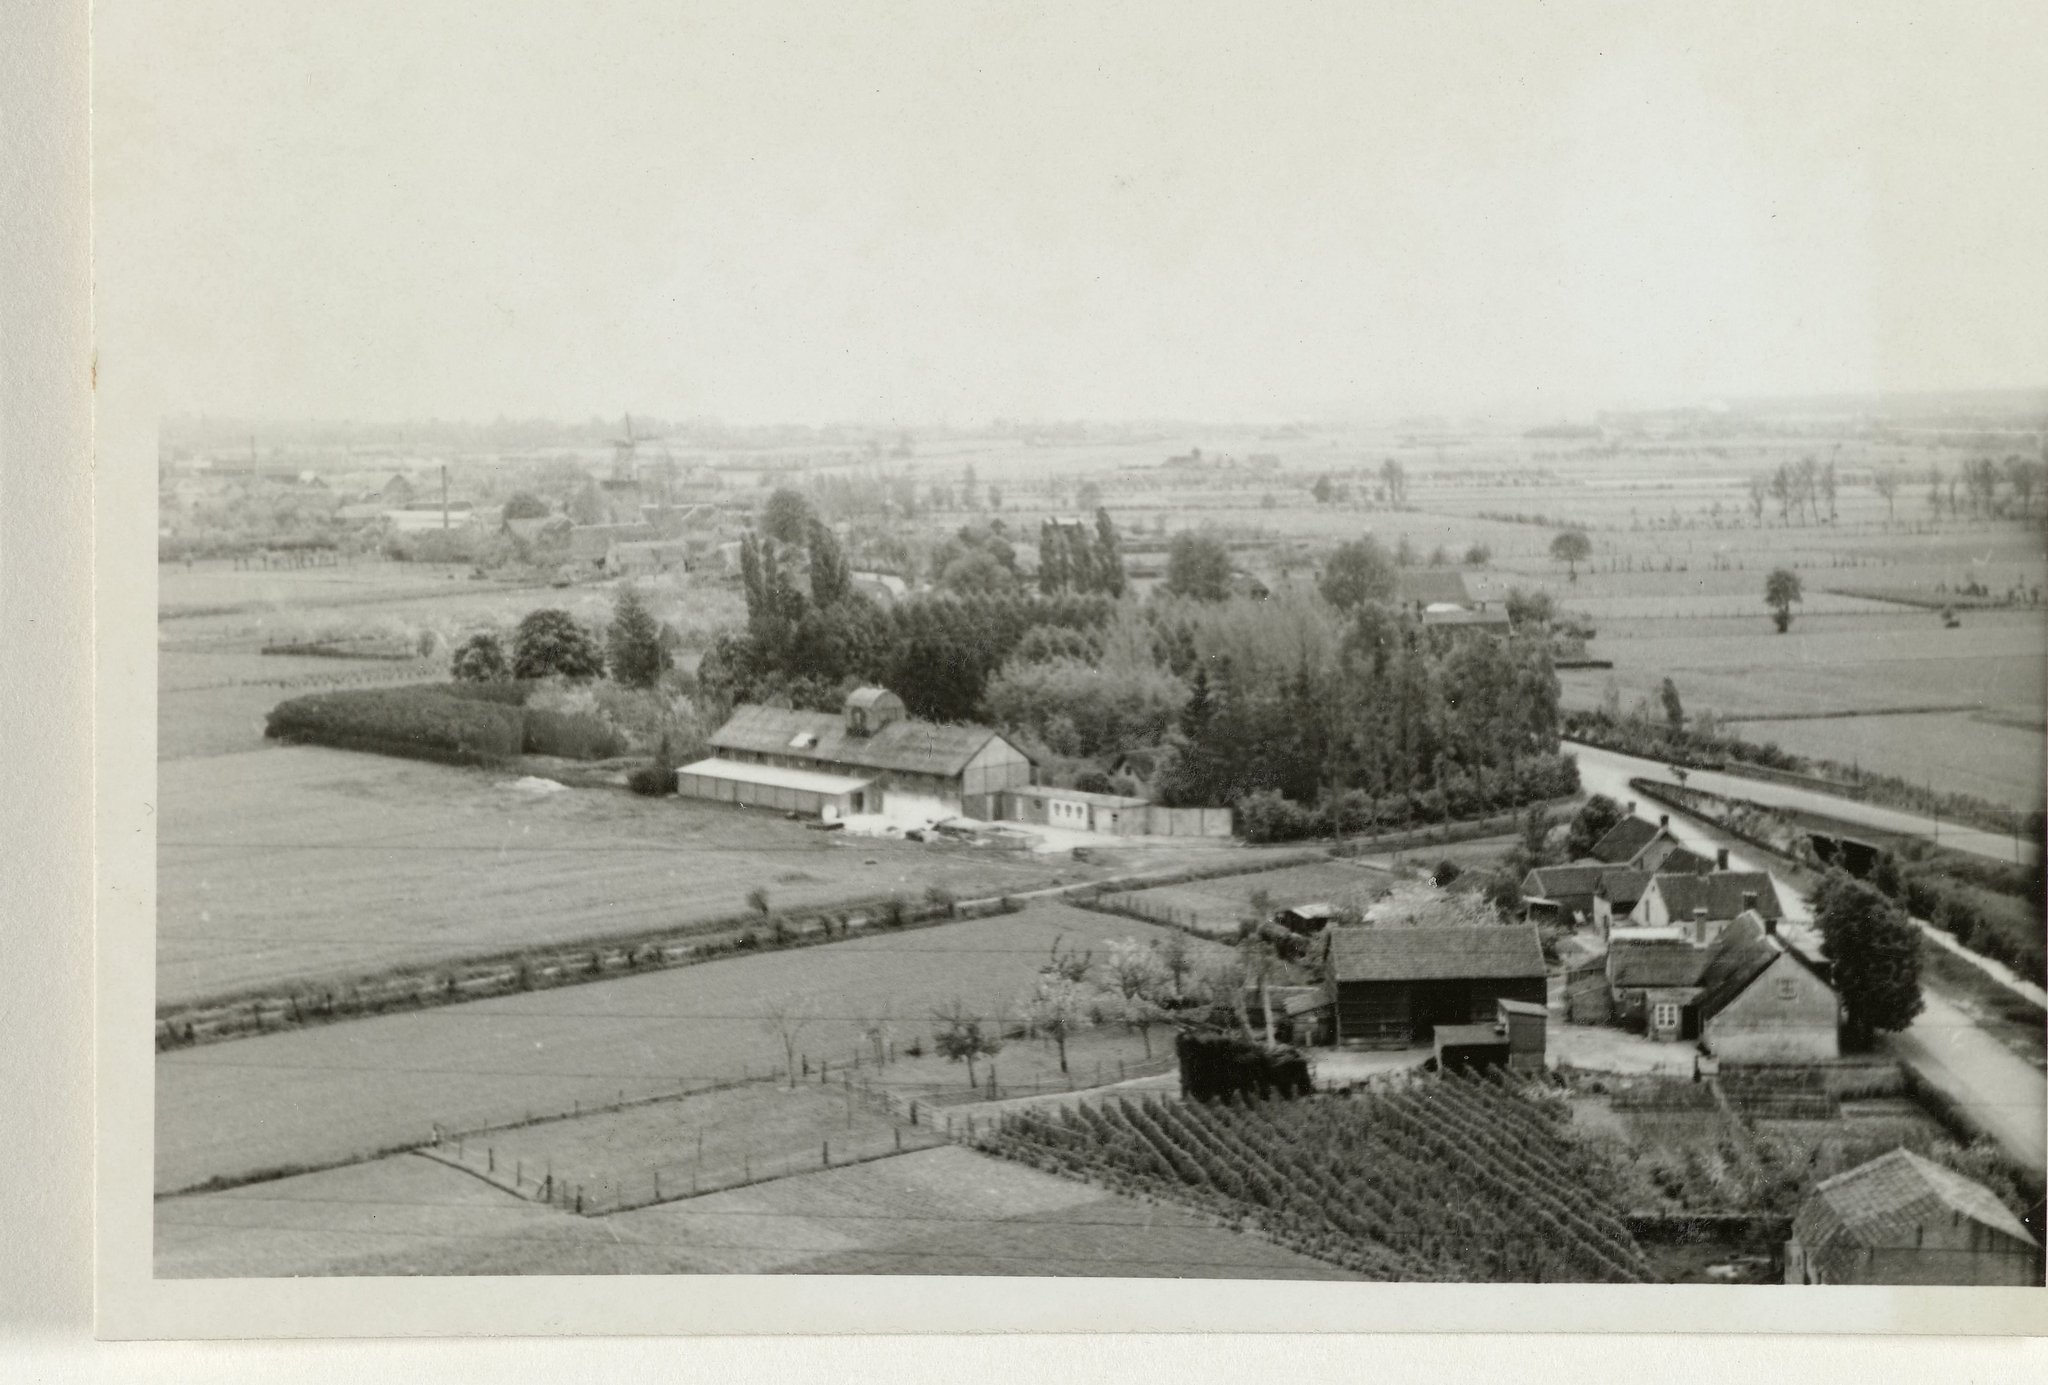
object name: photograph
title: Uitzicht vanaf watertoren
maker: Anonymous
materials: photographic support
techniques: gelatin silver print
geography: dongen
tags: occupation ~ war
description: UItzicht vanaf een watertoren over boerderijen en weilanden. Achterop staat: Blick v. Wasserturm Dongen in Richtung Breda.